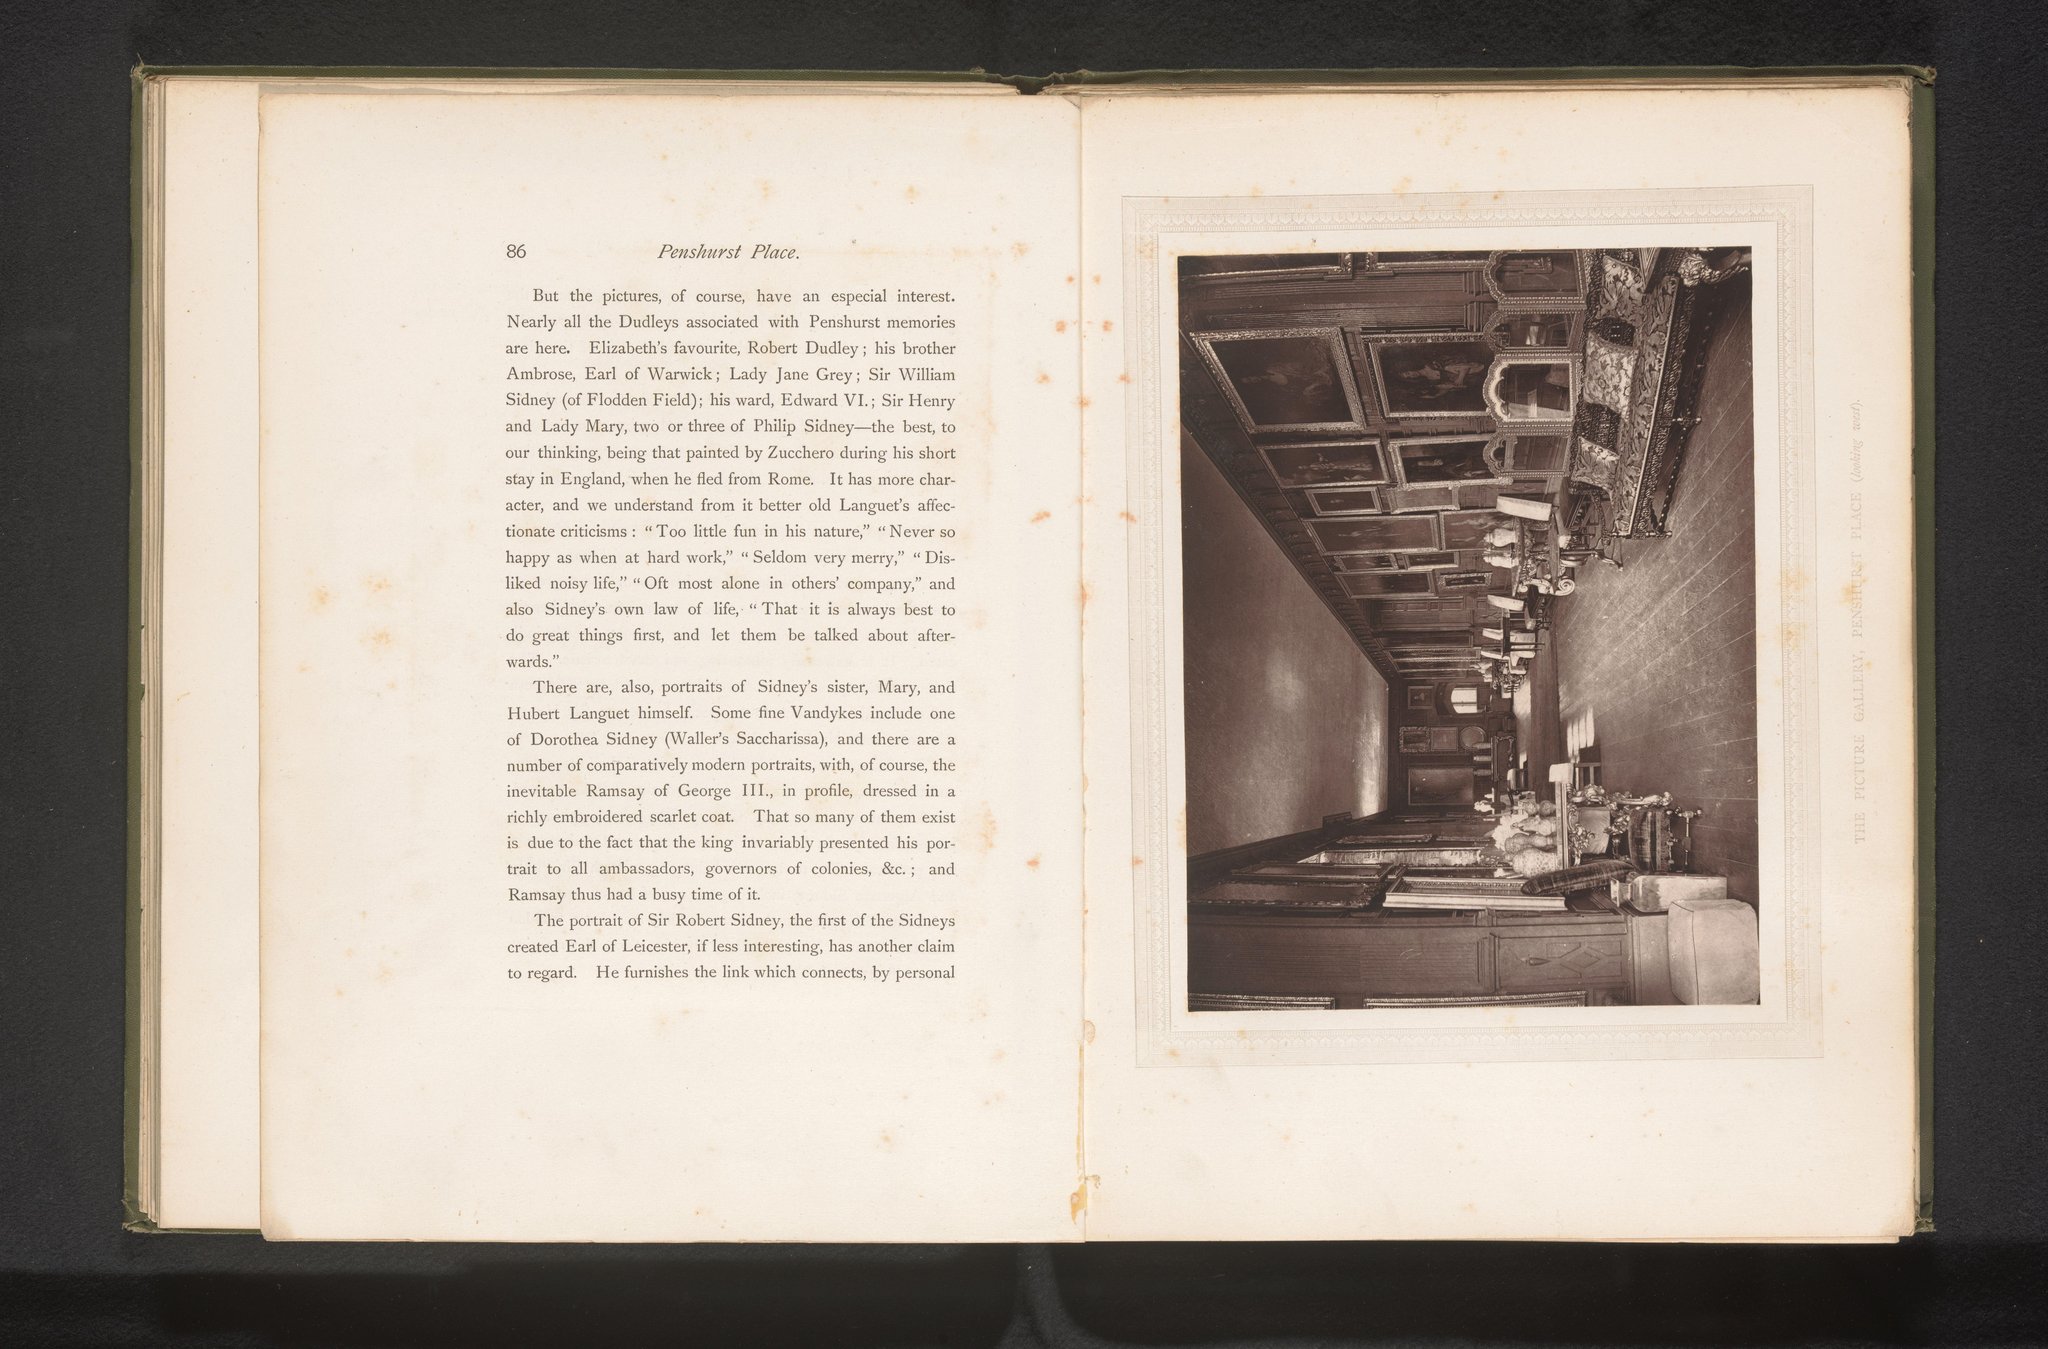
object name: photomechanical print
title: Interieur van een schilderijenzaal in Penshurst Place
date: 1866-1876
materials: paper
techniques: woodburytype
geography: penshurst place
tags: art collection, art gallery, interior of the house